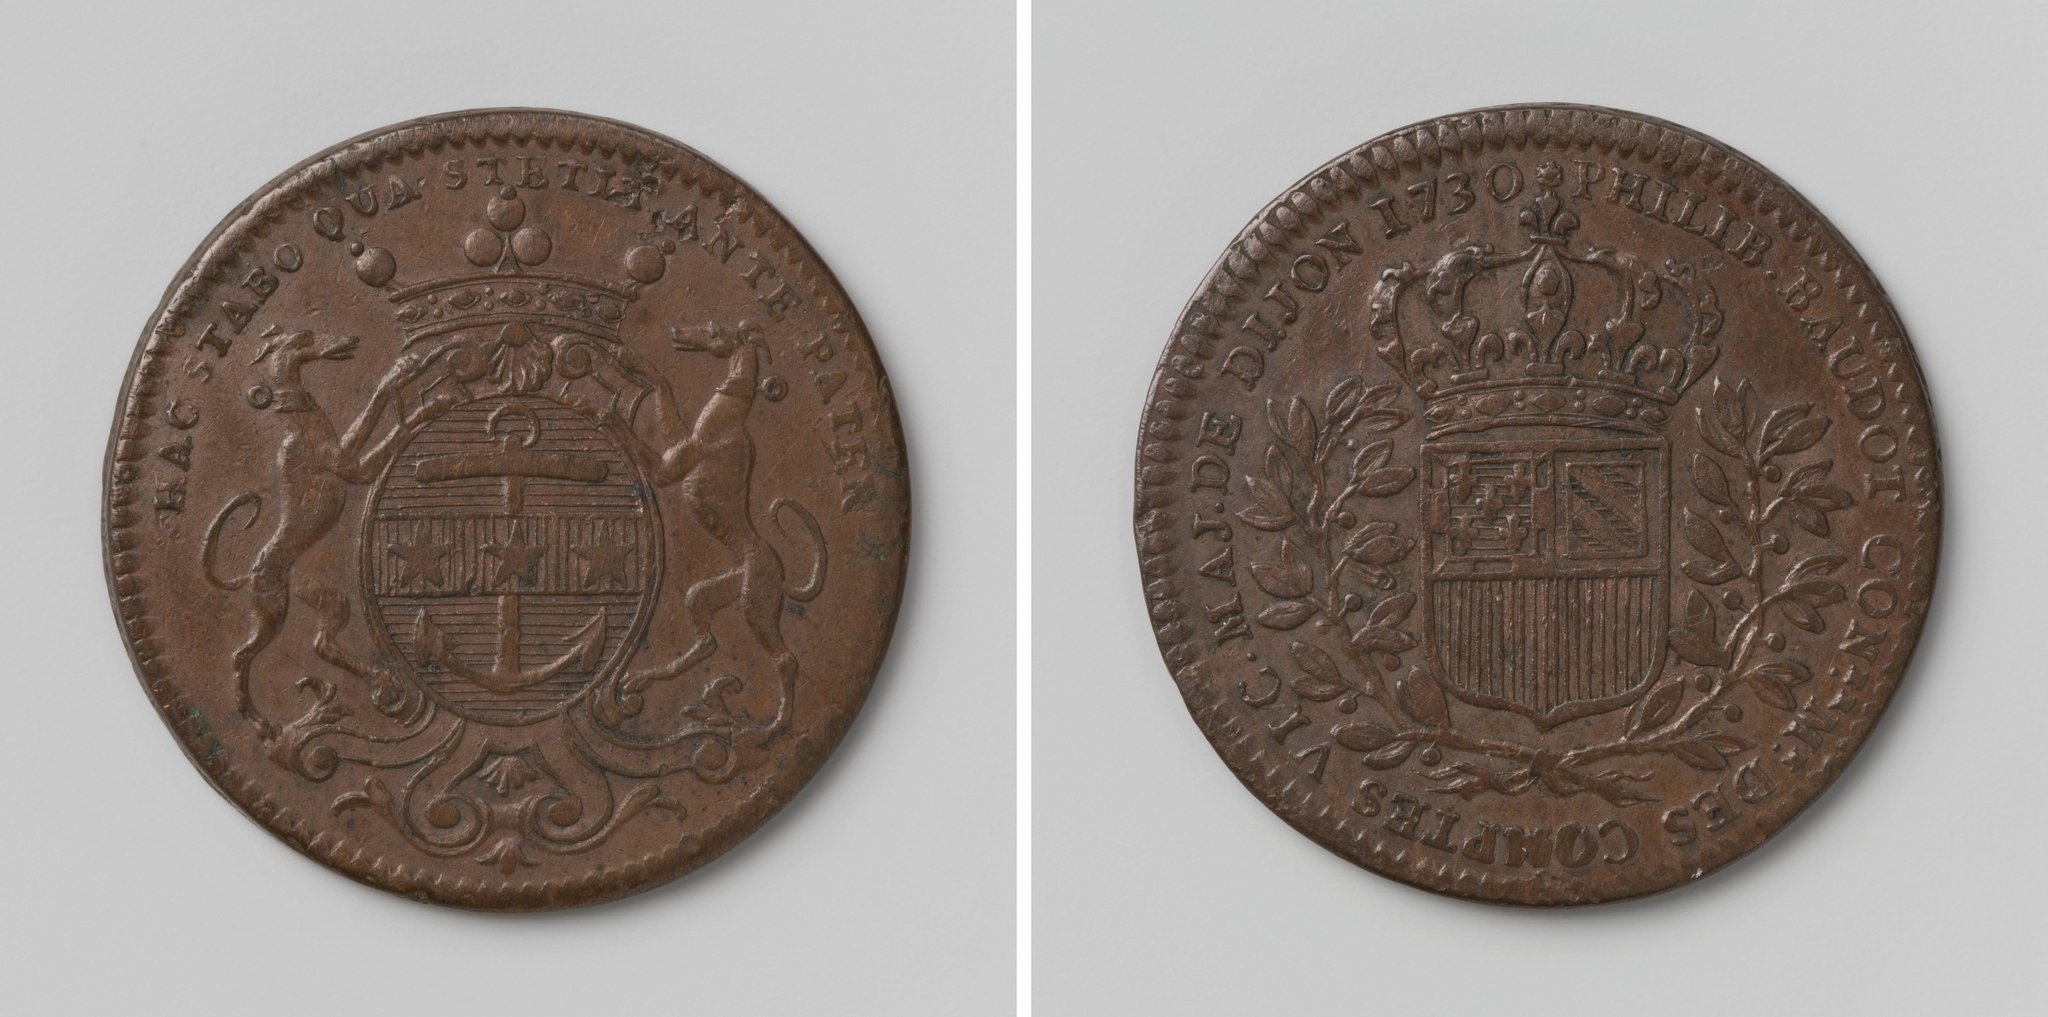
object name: jeton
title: Philibert Baudot, lid van de rekenkamer te Dijon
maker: francois joseph marteau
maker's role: medailleur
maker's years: -1757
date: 1730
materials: copper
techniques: striking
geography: paris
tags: philibert baudot, rekenkamer van dijon, dijon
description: Koperen penning. Voorzijde: gekroond wapenschild, geflankeerd door twee honden binnen omschrift. Keerzijde: gekroond wapenschild op twee lauwertakken binnen omschrift